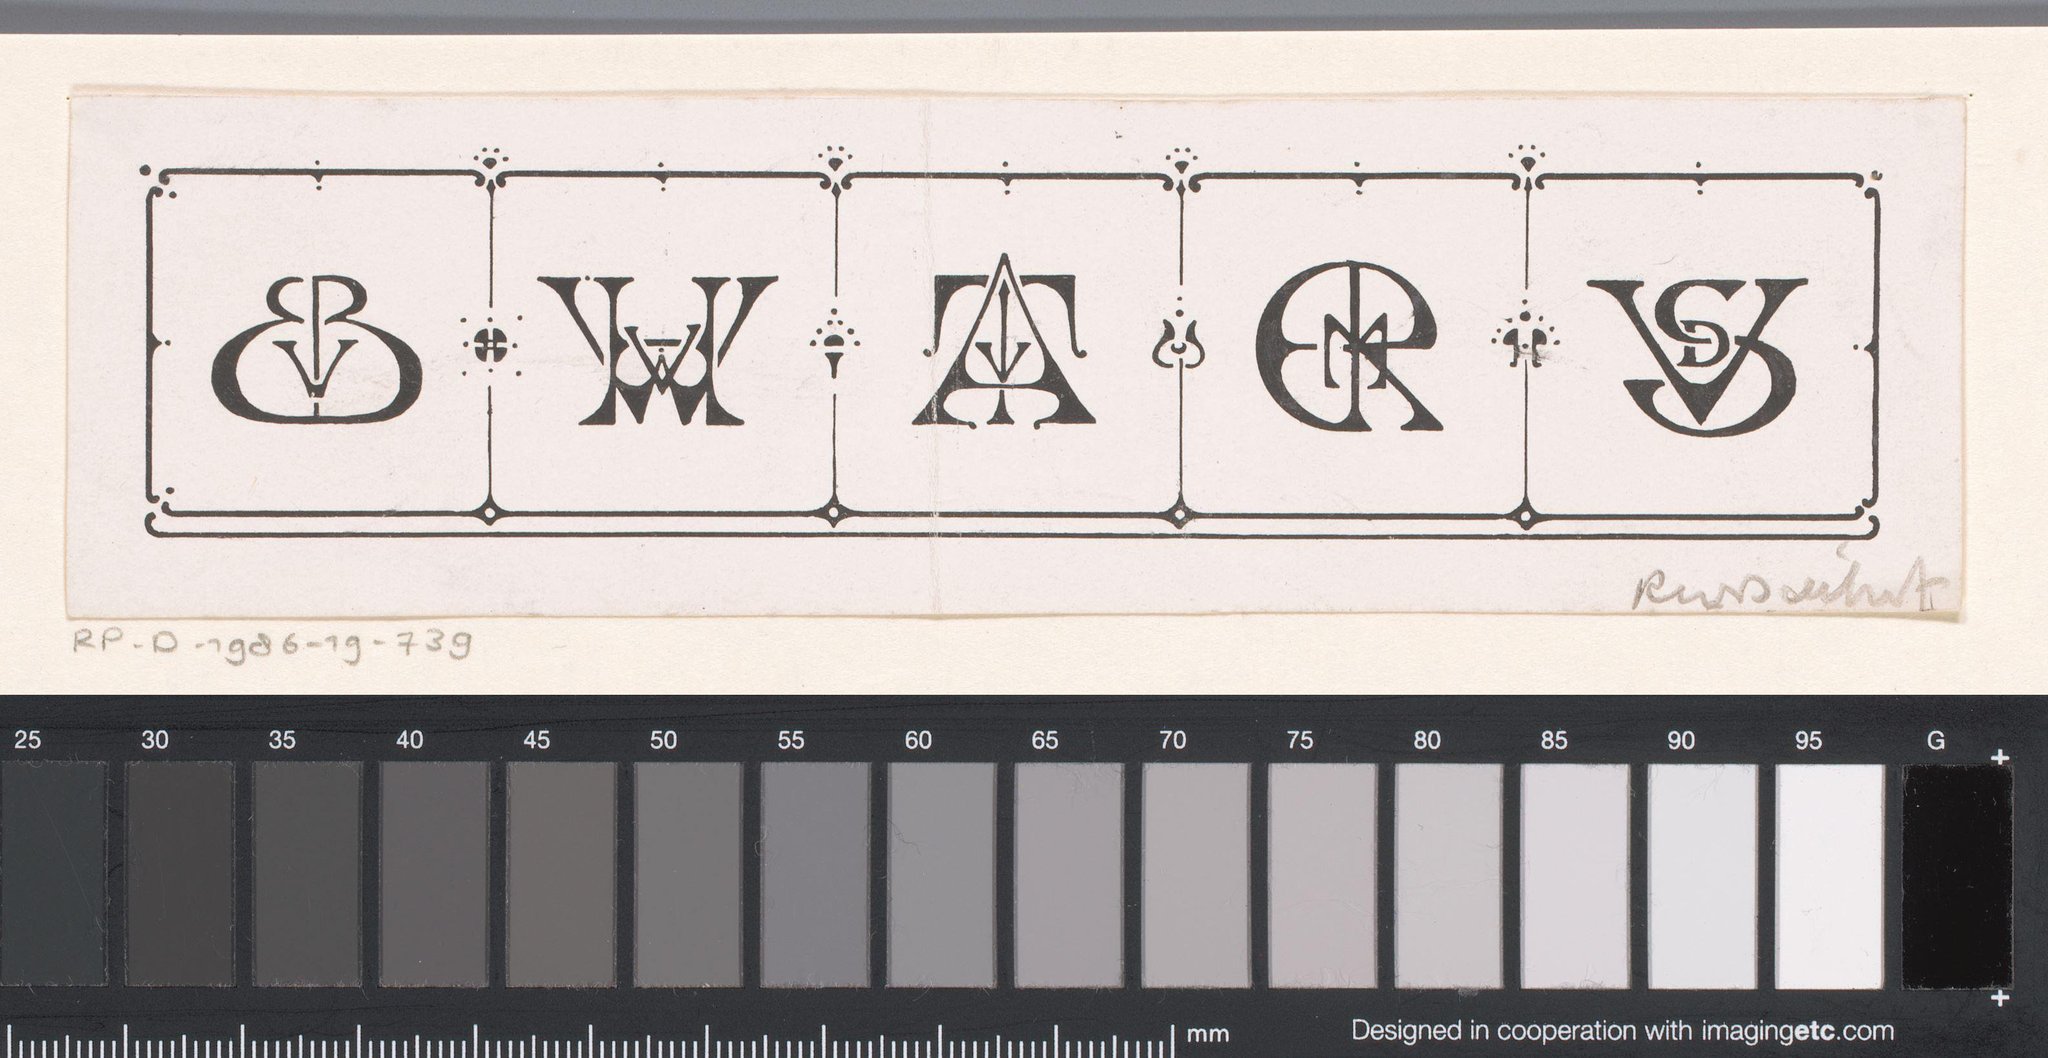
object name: photomechanical print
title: Titelhoofd met vijf monogrammen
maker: reinier willem petrus de vries (1874-1953)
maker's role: draughtsman, print maker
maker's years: 1874-1953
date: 1906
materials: paper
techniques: printing block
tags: magic mathematical figures; magic numbers, words, monograms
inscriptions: name: ‘RWPdeVriesJr’, collector's mark: ‘R:MVS.’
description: De monogrammen zijn gebruikt als titelhoofd voor het artikel 'Over monogrammen' van R.W.P. de Vries Jr., verschenen in: De vrouw en haar huis, 1906.